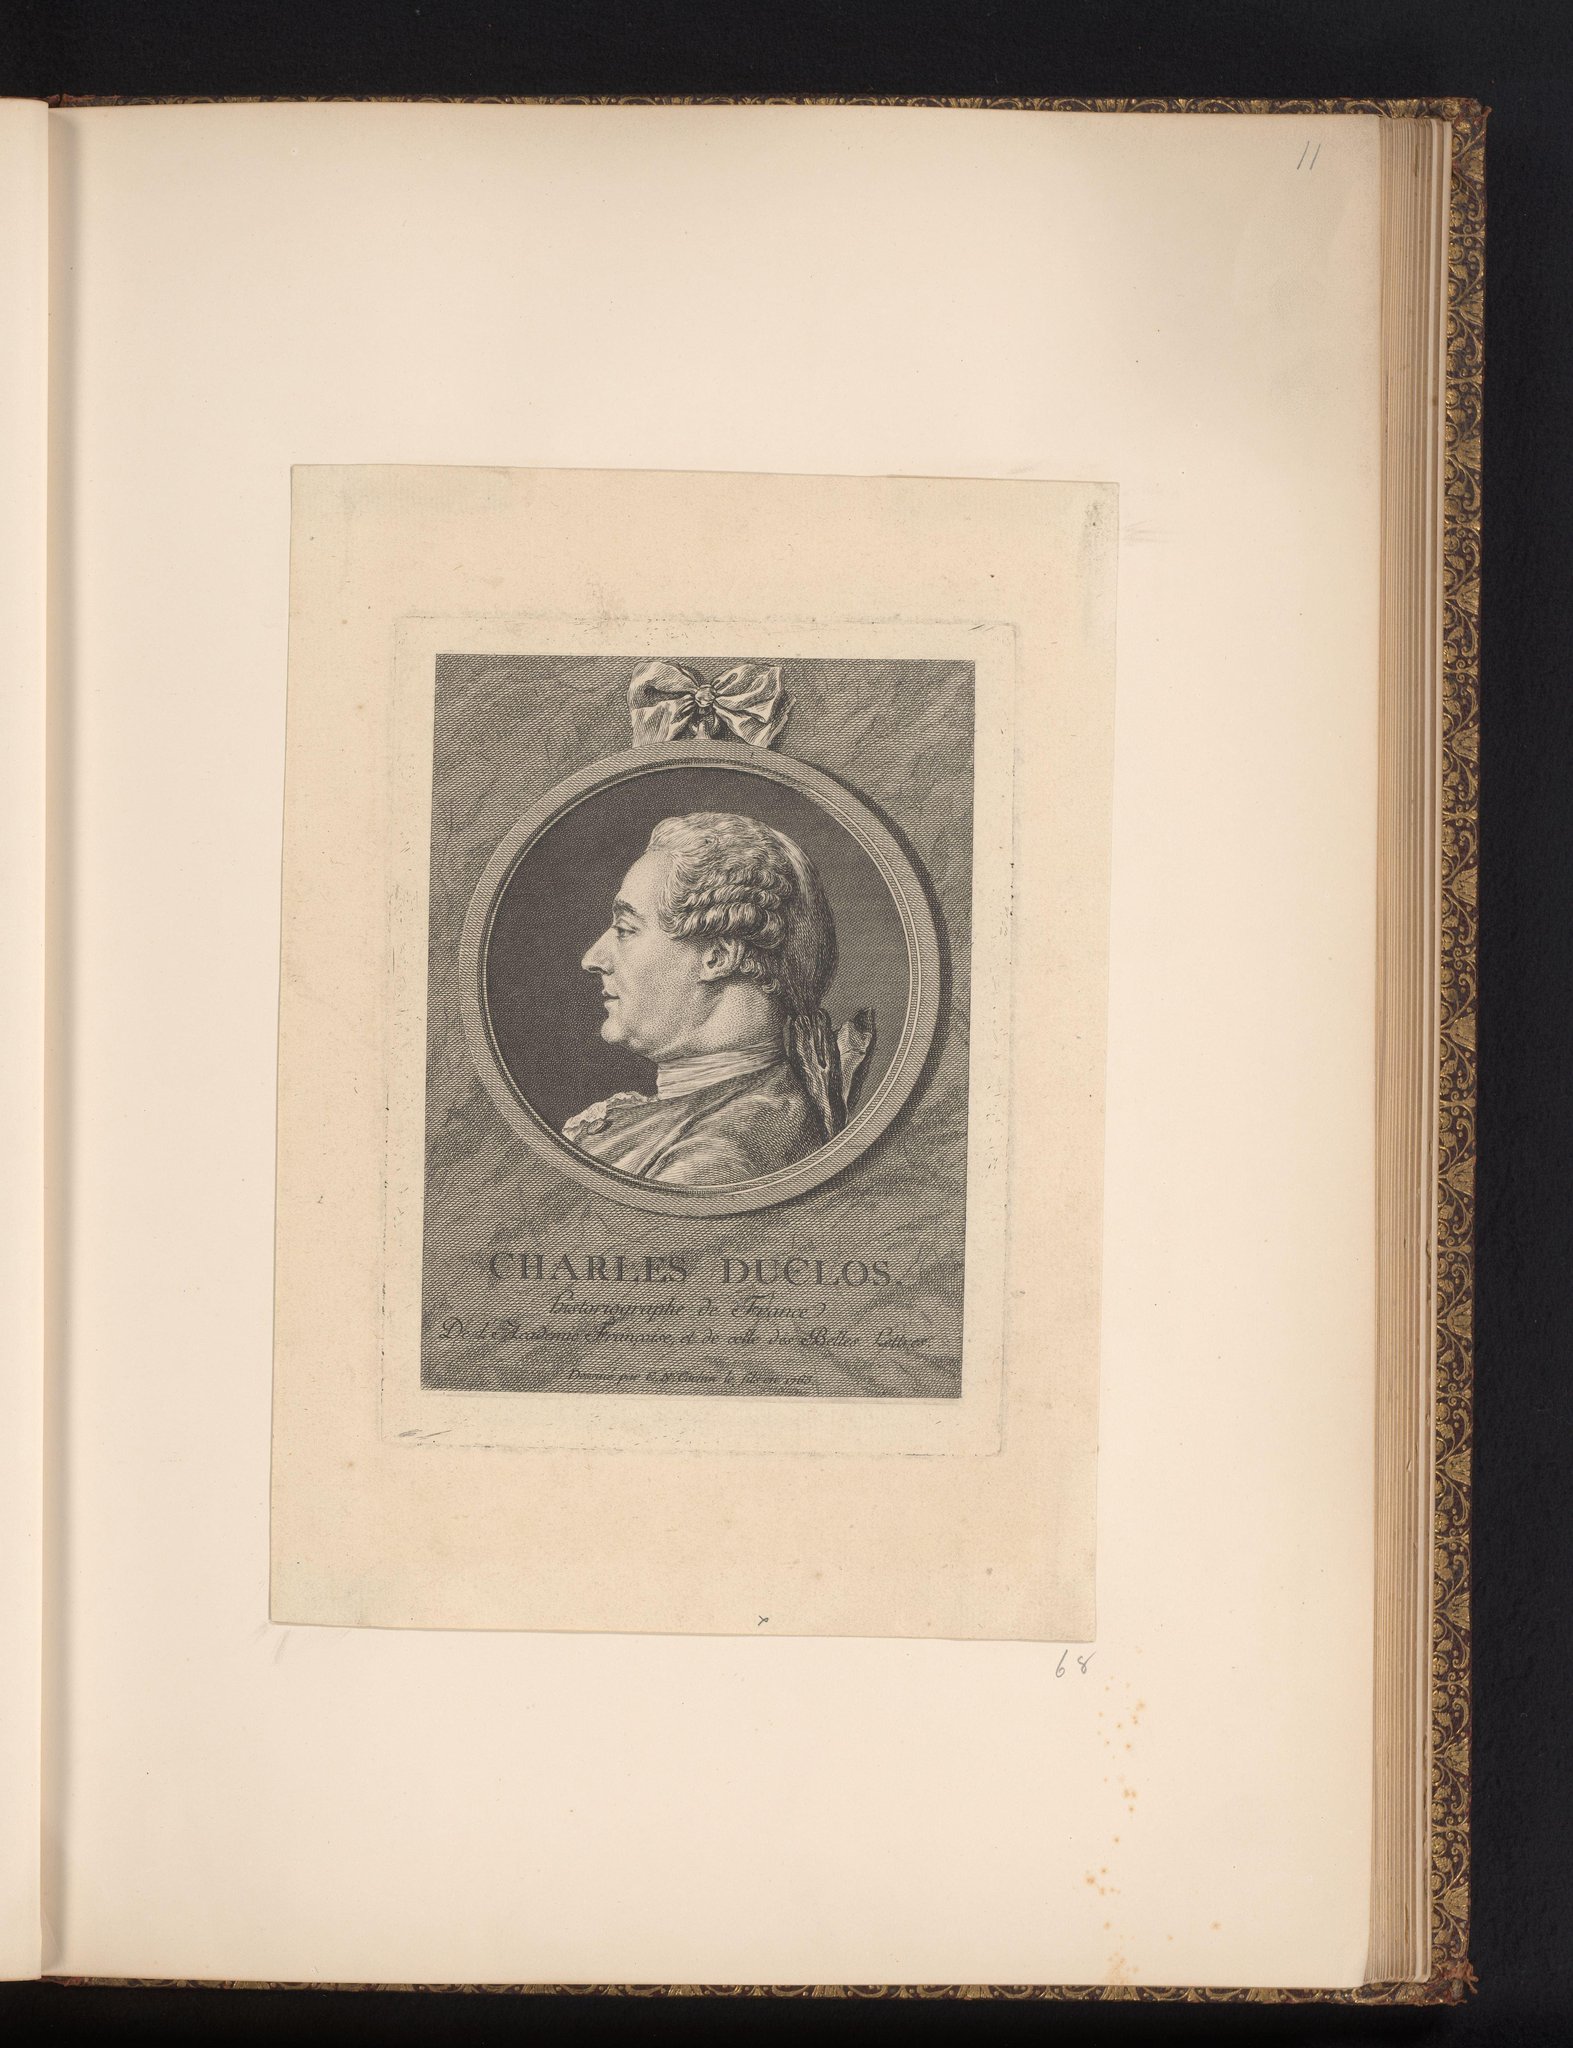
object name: album leaf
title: Charles Duclos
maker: charles nicolas cochin (ii)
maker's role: draughtsman, print maker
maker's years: 1715-1790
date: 1763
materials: paper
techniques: engraving, etching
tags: historical persons, portrait of a writer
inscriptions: date